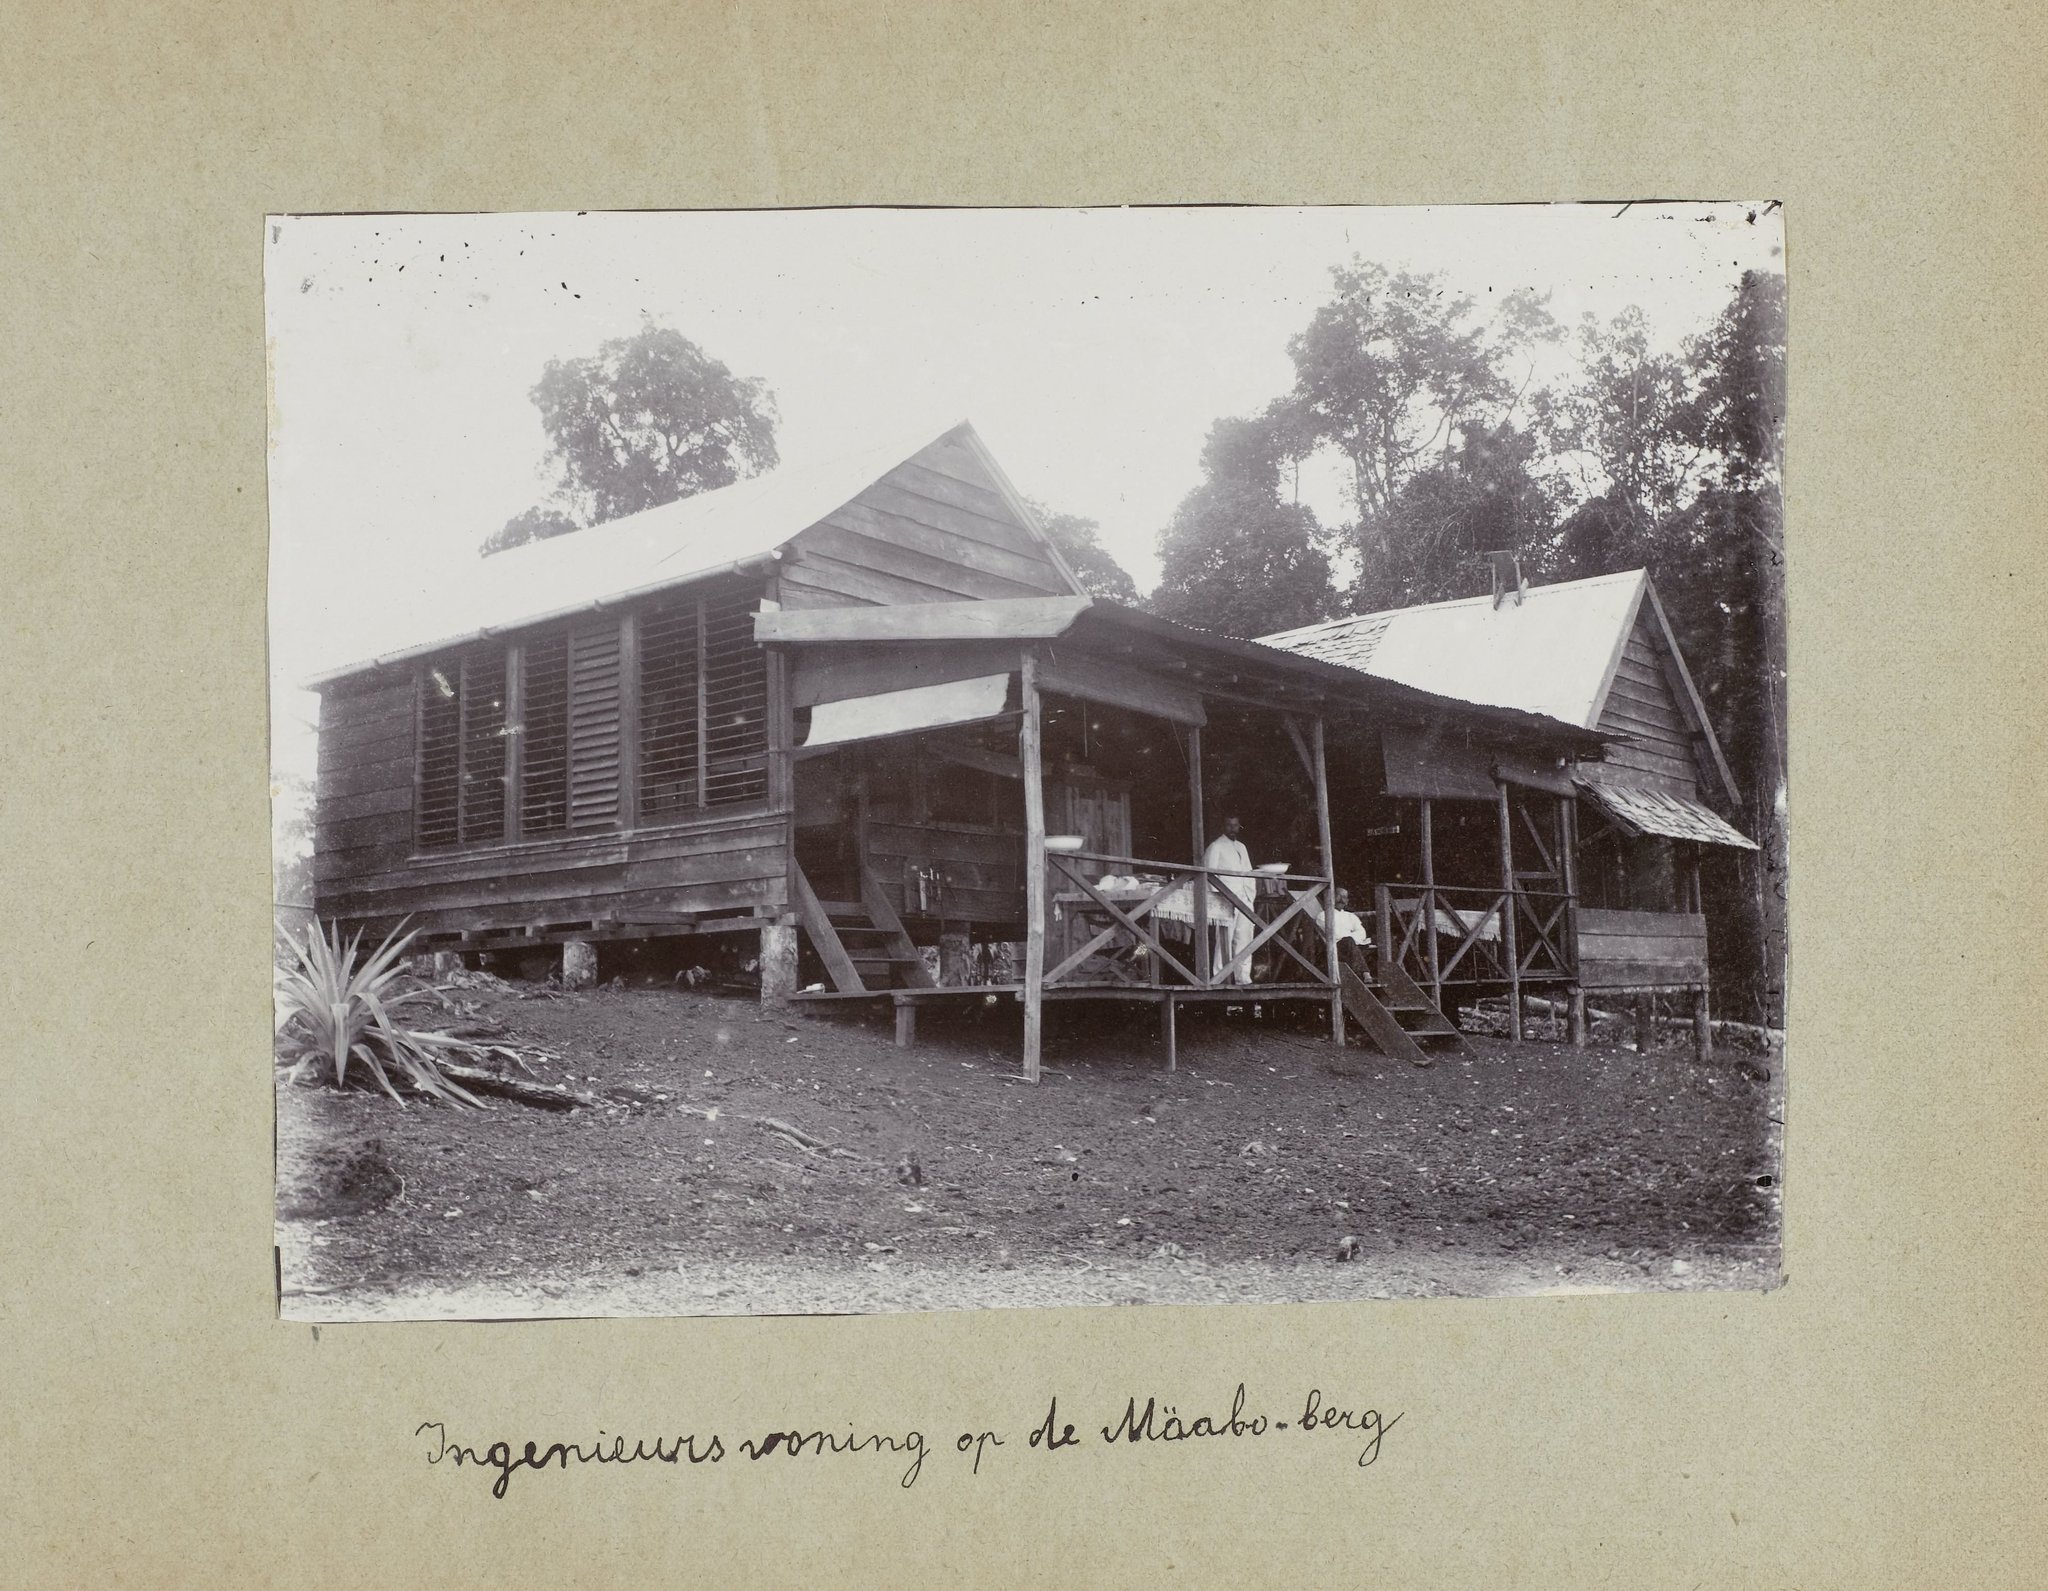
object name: photograph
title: Ingenieurswoning op de Mäabo-berg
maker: augusta curiel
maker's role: fotograaf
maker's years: 1873-1937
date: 1905-1910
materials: photographic support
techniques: photography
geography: suriname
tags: jacob evert wesenhagen, railway, tramway; rack railway, suriname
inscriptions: inscription: ‘Ingenieurswoning op de Mäabo-berg’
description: De ingenieurswoning op de Mäabo Heuvel. Foto in het fotoalbum over de aanleg van de Lawaspoorweg in Suriname in de jaren 1903-1912. Onderdeel van een groep objecten afkomstig van de familie Wesenhagen in Suriname.